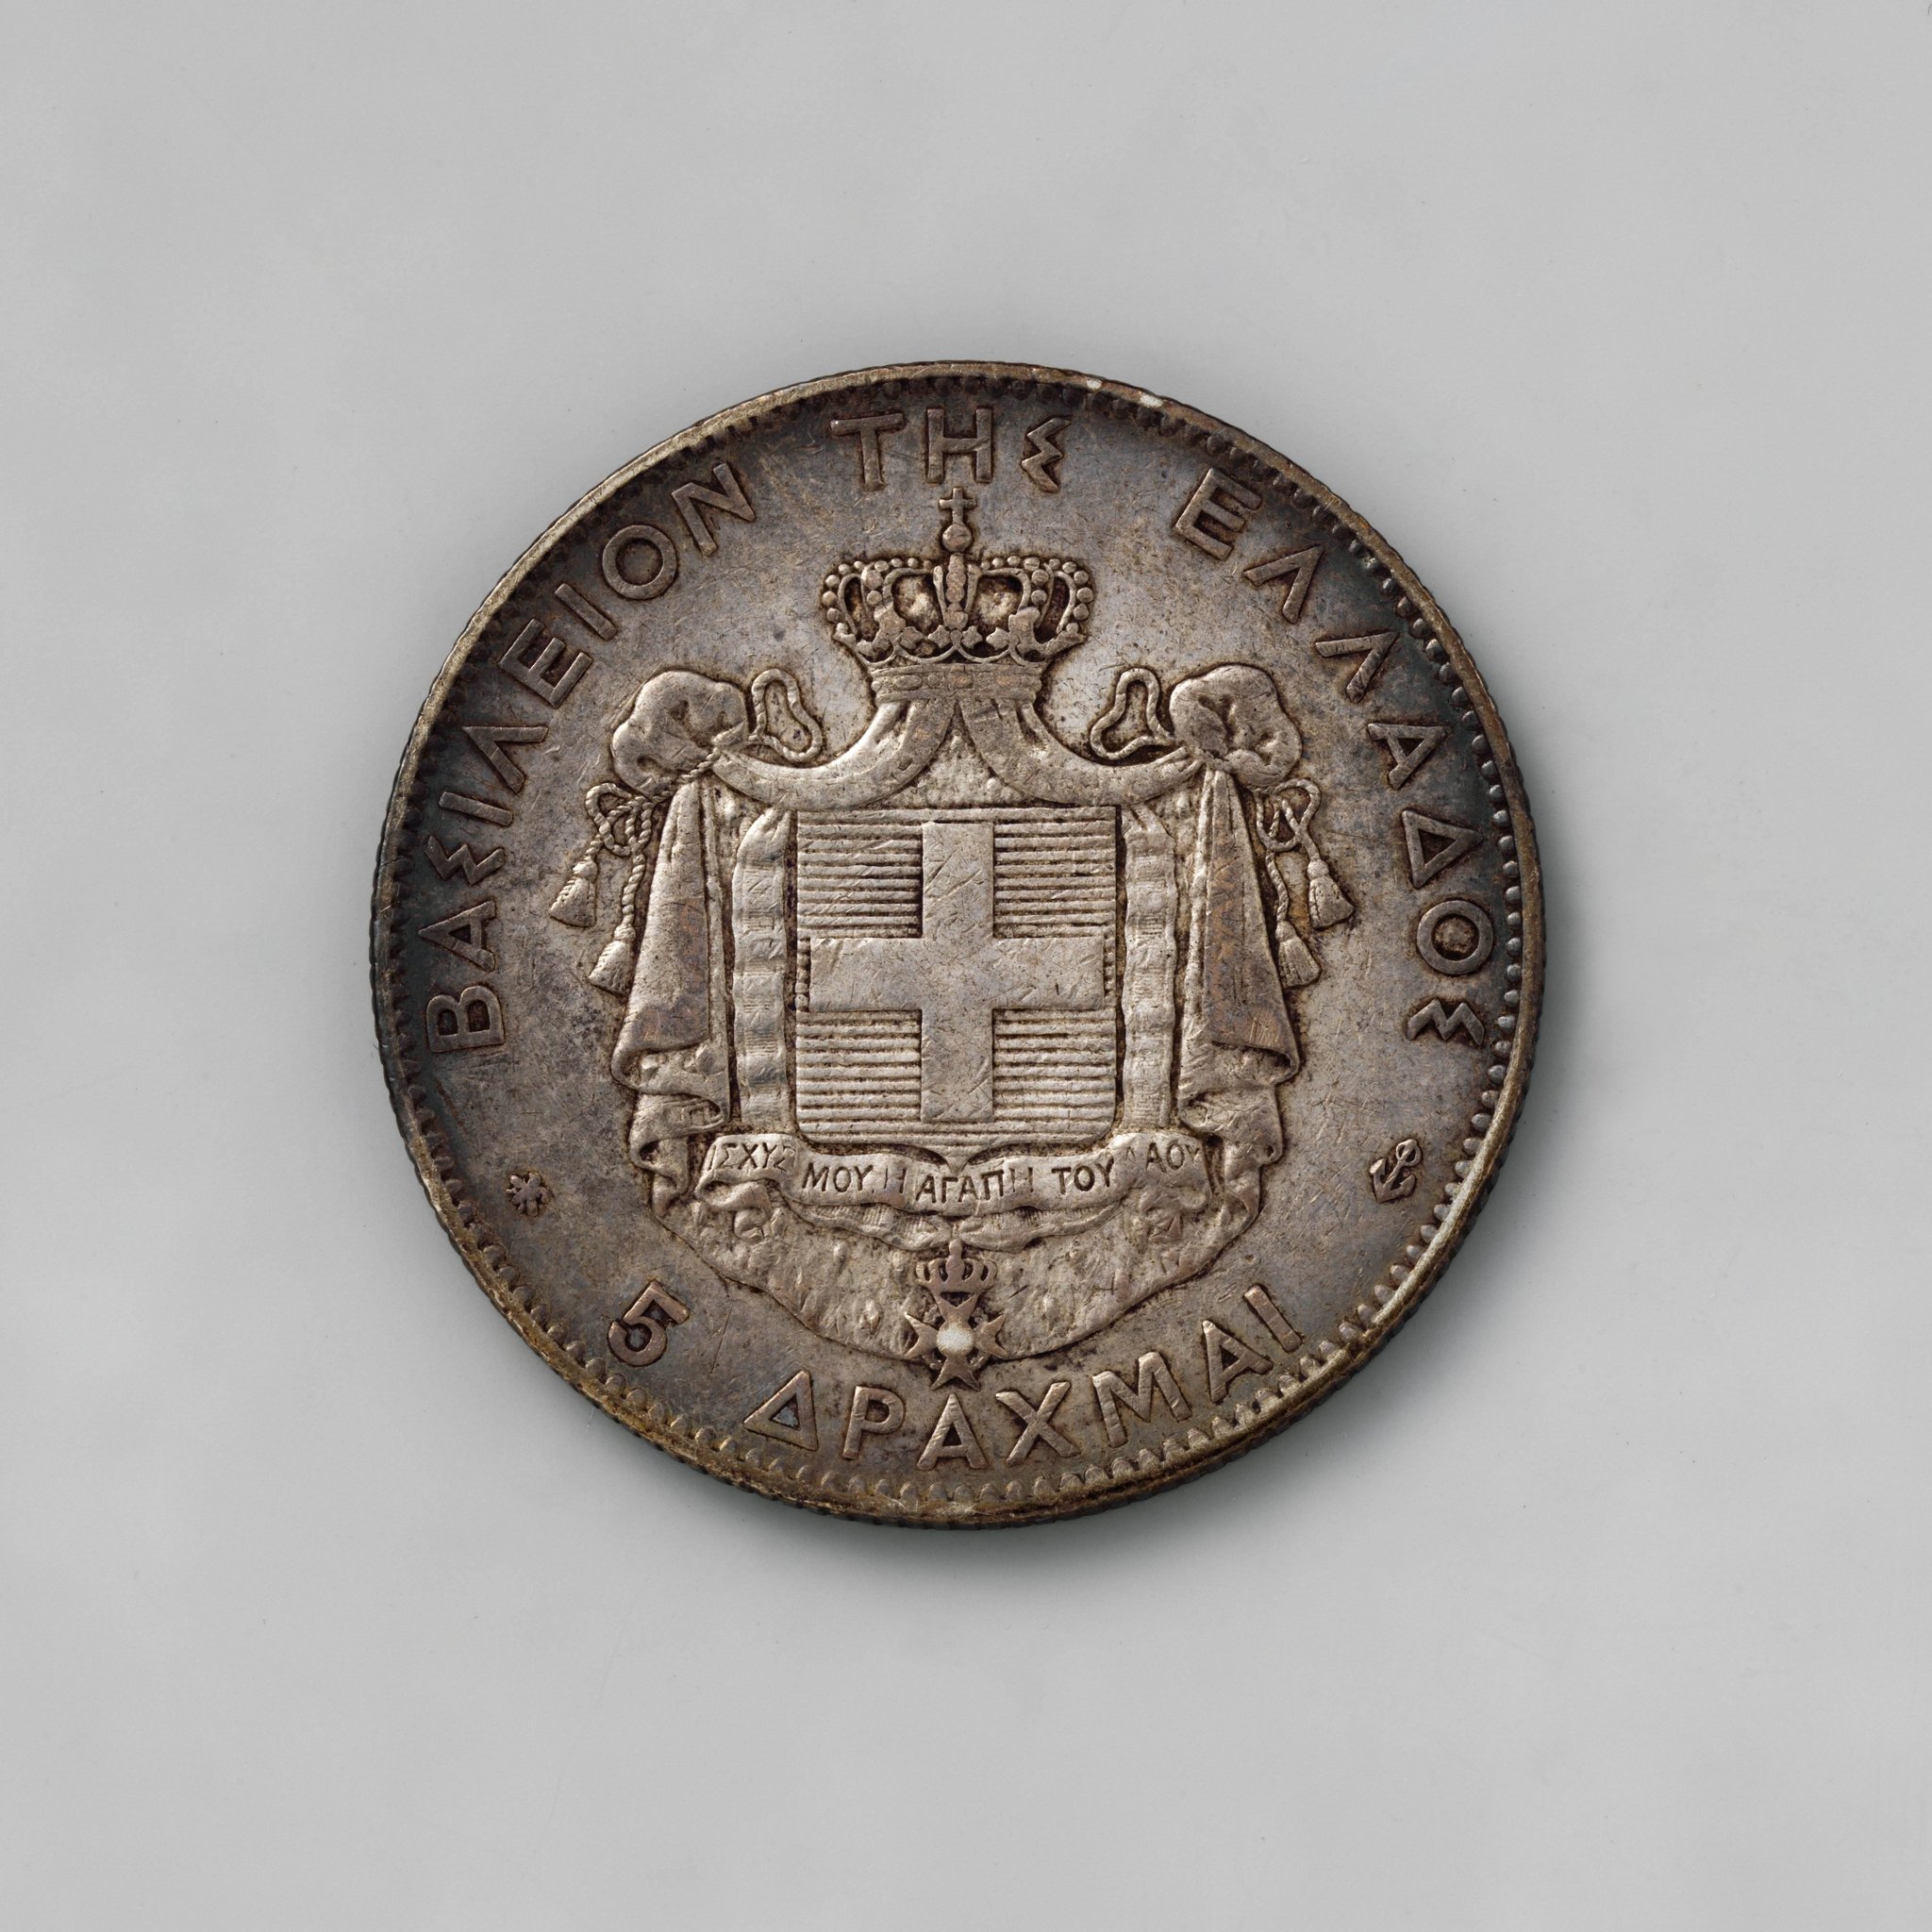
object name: coin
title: Griekenland, koning Georgios I, 5 drachmen,1875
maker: Anonymous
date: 1875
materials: silver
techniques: striking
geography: paris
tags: copenhagen (city)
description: Zilveren munt. Voorzijde: hoofd van de koning naar links. Jaartal onderaan in omschrift. Rechts daarvan letter A [=Parijs]. Keerzijde: op mantel met kroon door ridderorde met juweel omhangen Grieks wapenschild. Waarde-aanduiding onderaan in omschrift. Kartelrand. Geslagen in Parijs tijdens de zogenaamde Latijnse Muntunie.